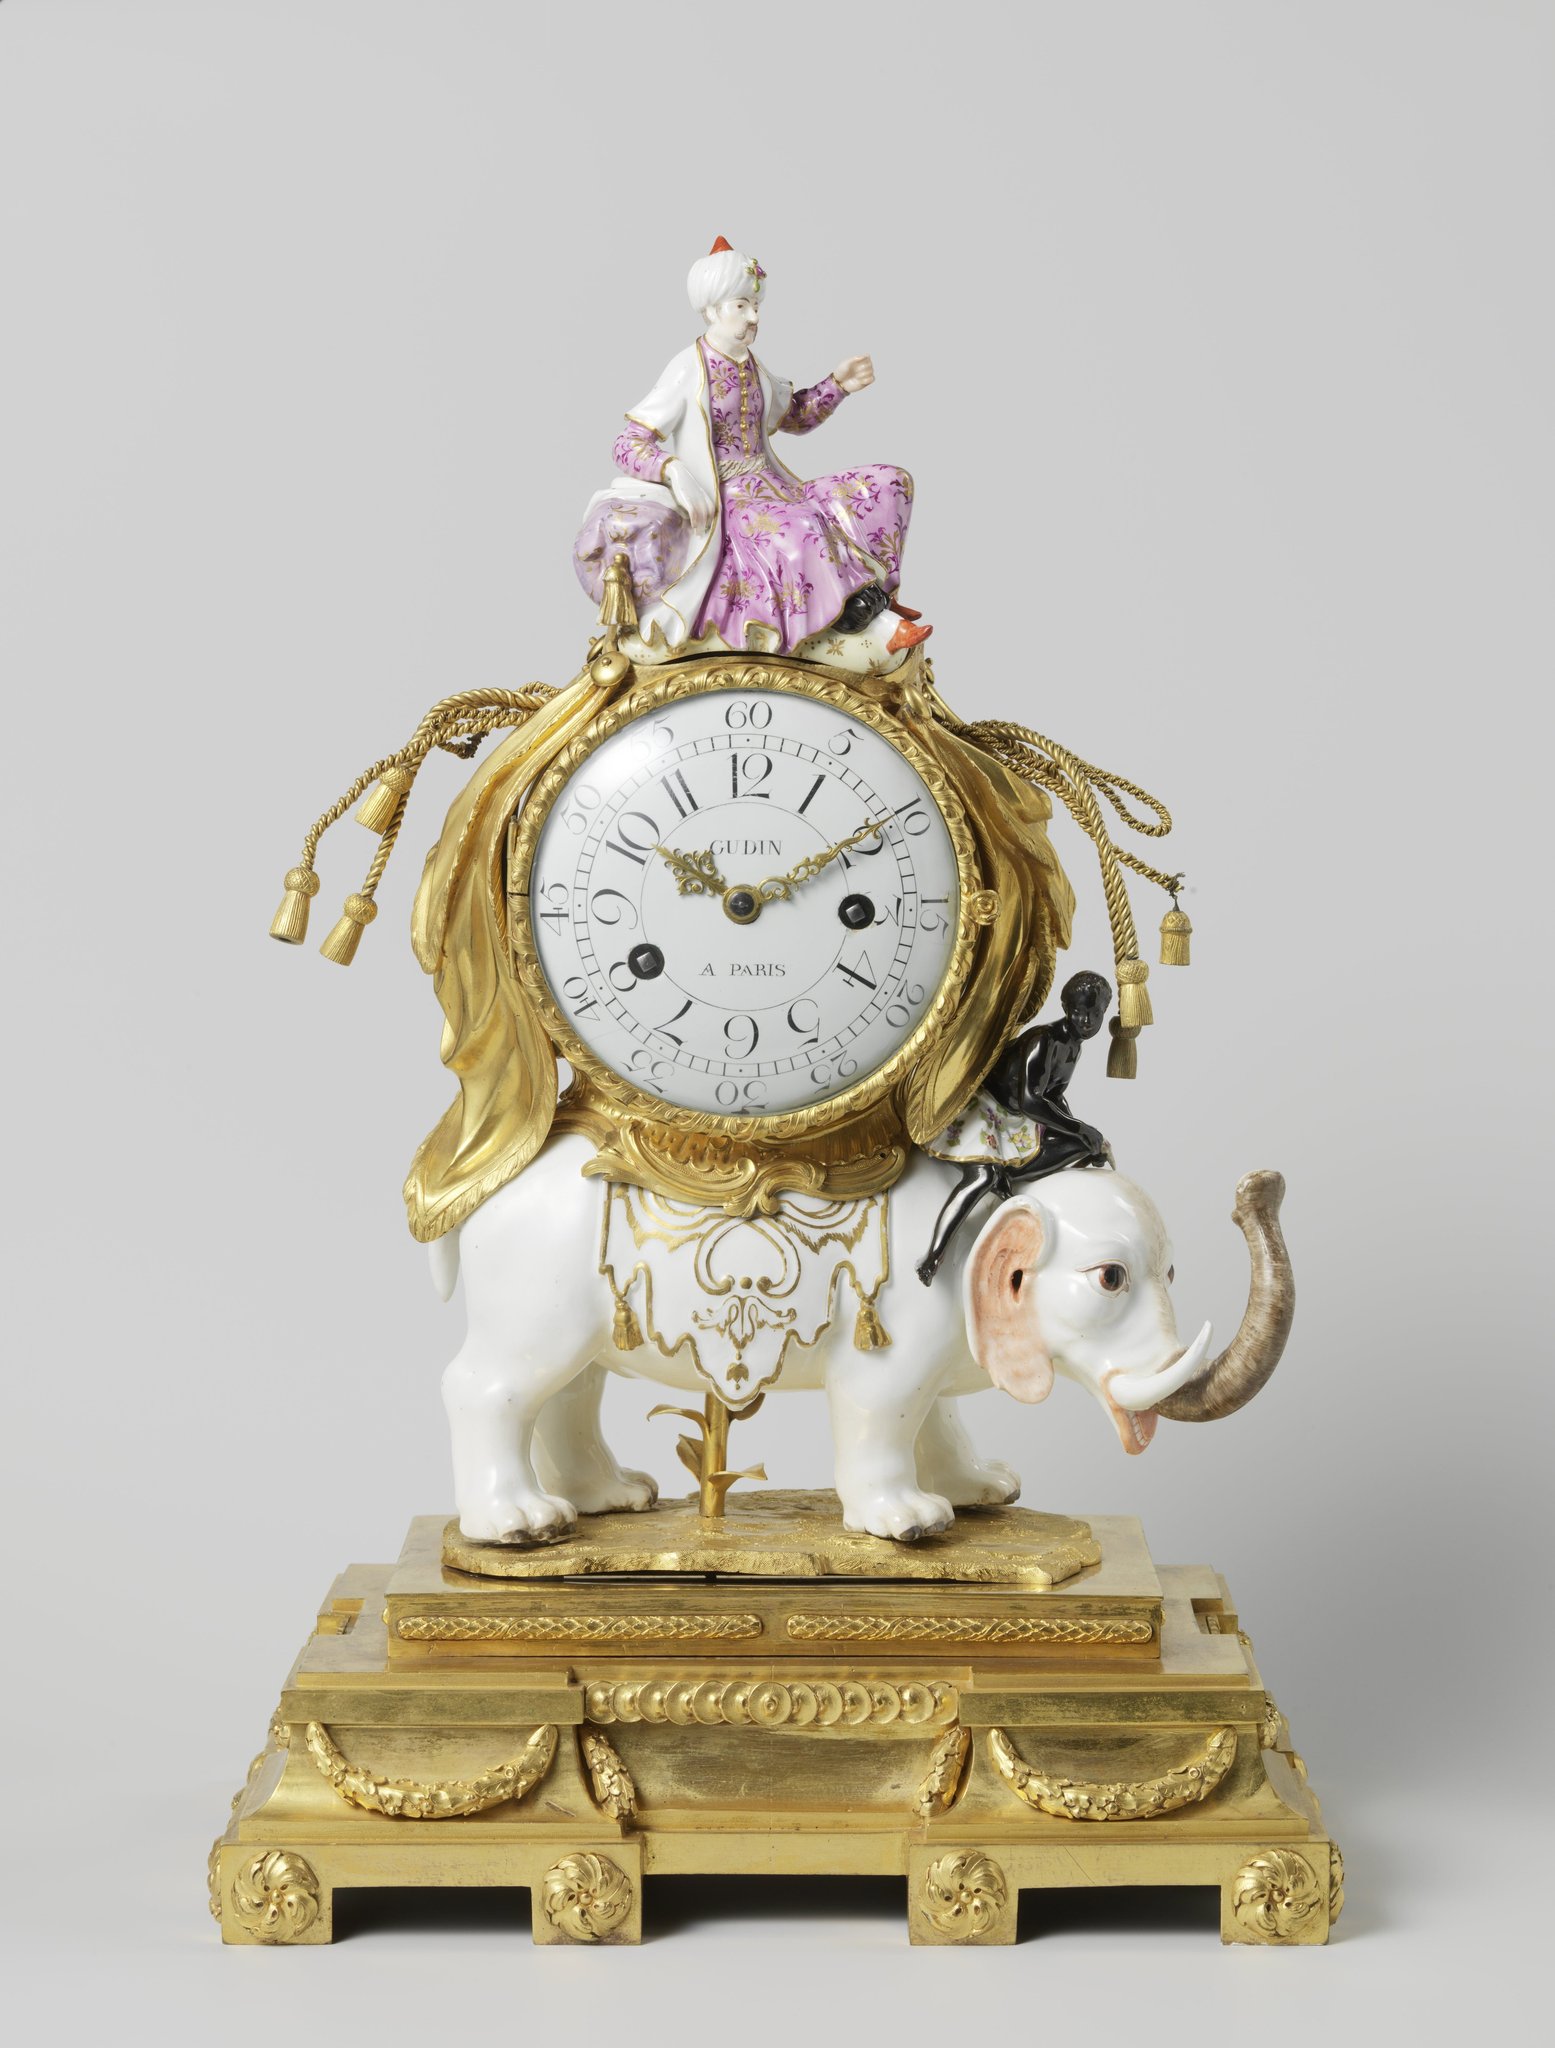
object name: clock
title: Mantle clock (pendule)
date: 1753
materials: bronze, porcelain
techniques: gilding, painted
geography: meissen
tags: trunked animals: elephant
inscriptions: signature: ‘GUDIN/ A PARIS’, signature: ‘Gudin AParis’, inscription: ‘Gadois Tilleres 1839/ M Godin(?)’, inscription: ‘Bussot(?) 9bre 1753/ Gadois Tillieris(?) 1837/ Tillierest(?) Gadois 1837/ aout/ M S Gudin(?)’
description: These Meissen porcelain figures were incorporated in a clock at the initiative of a Parisian marchand-mercier (dealer in luxury goods), probably around 1755. Soon thereafter the entire object was mounted on a Neoclassical gilt-bronze (ormolu) base.